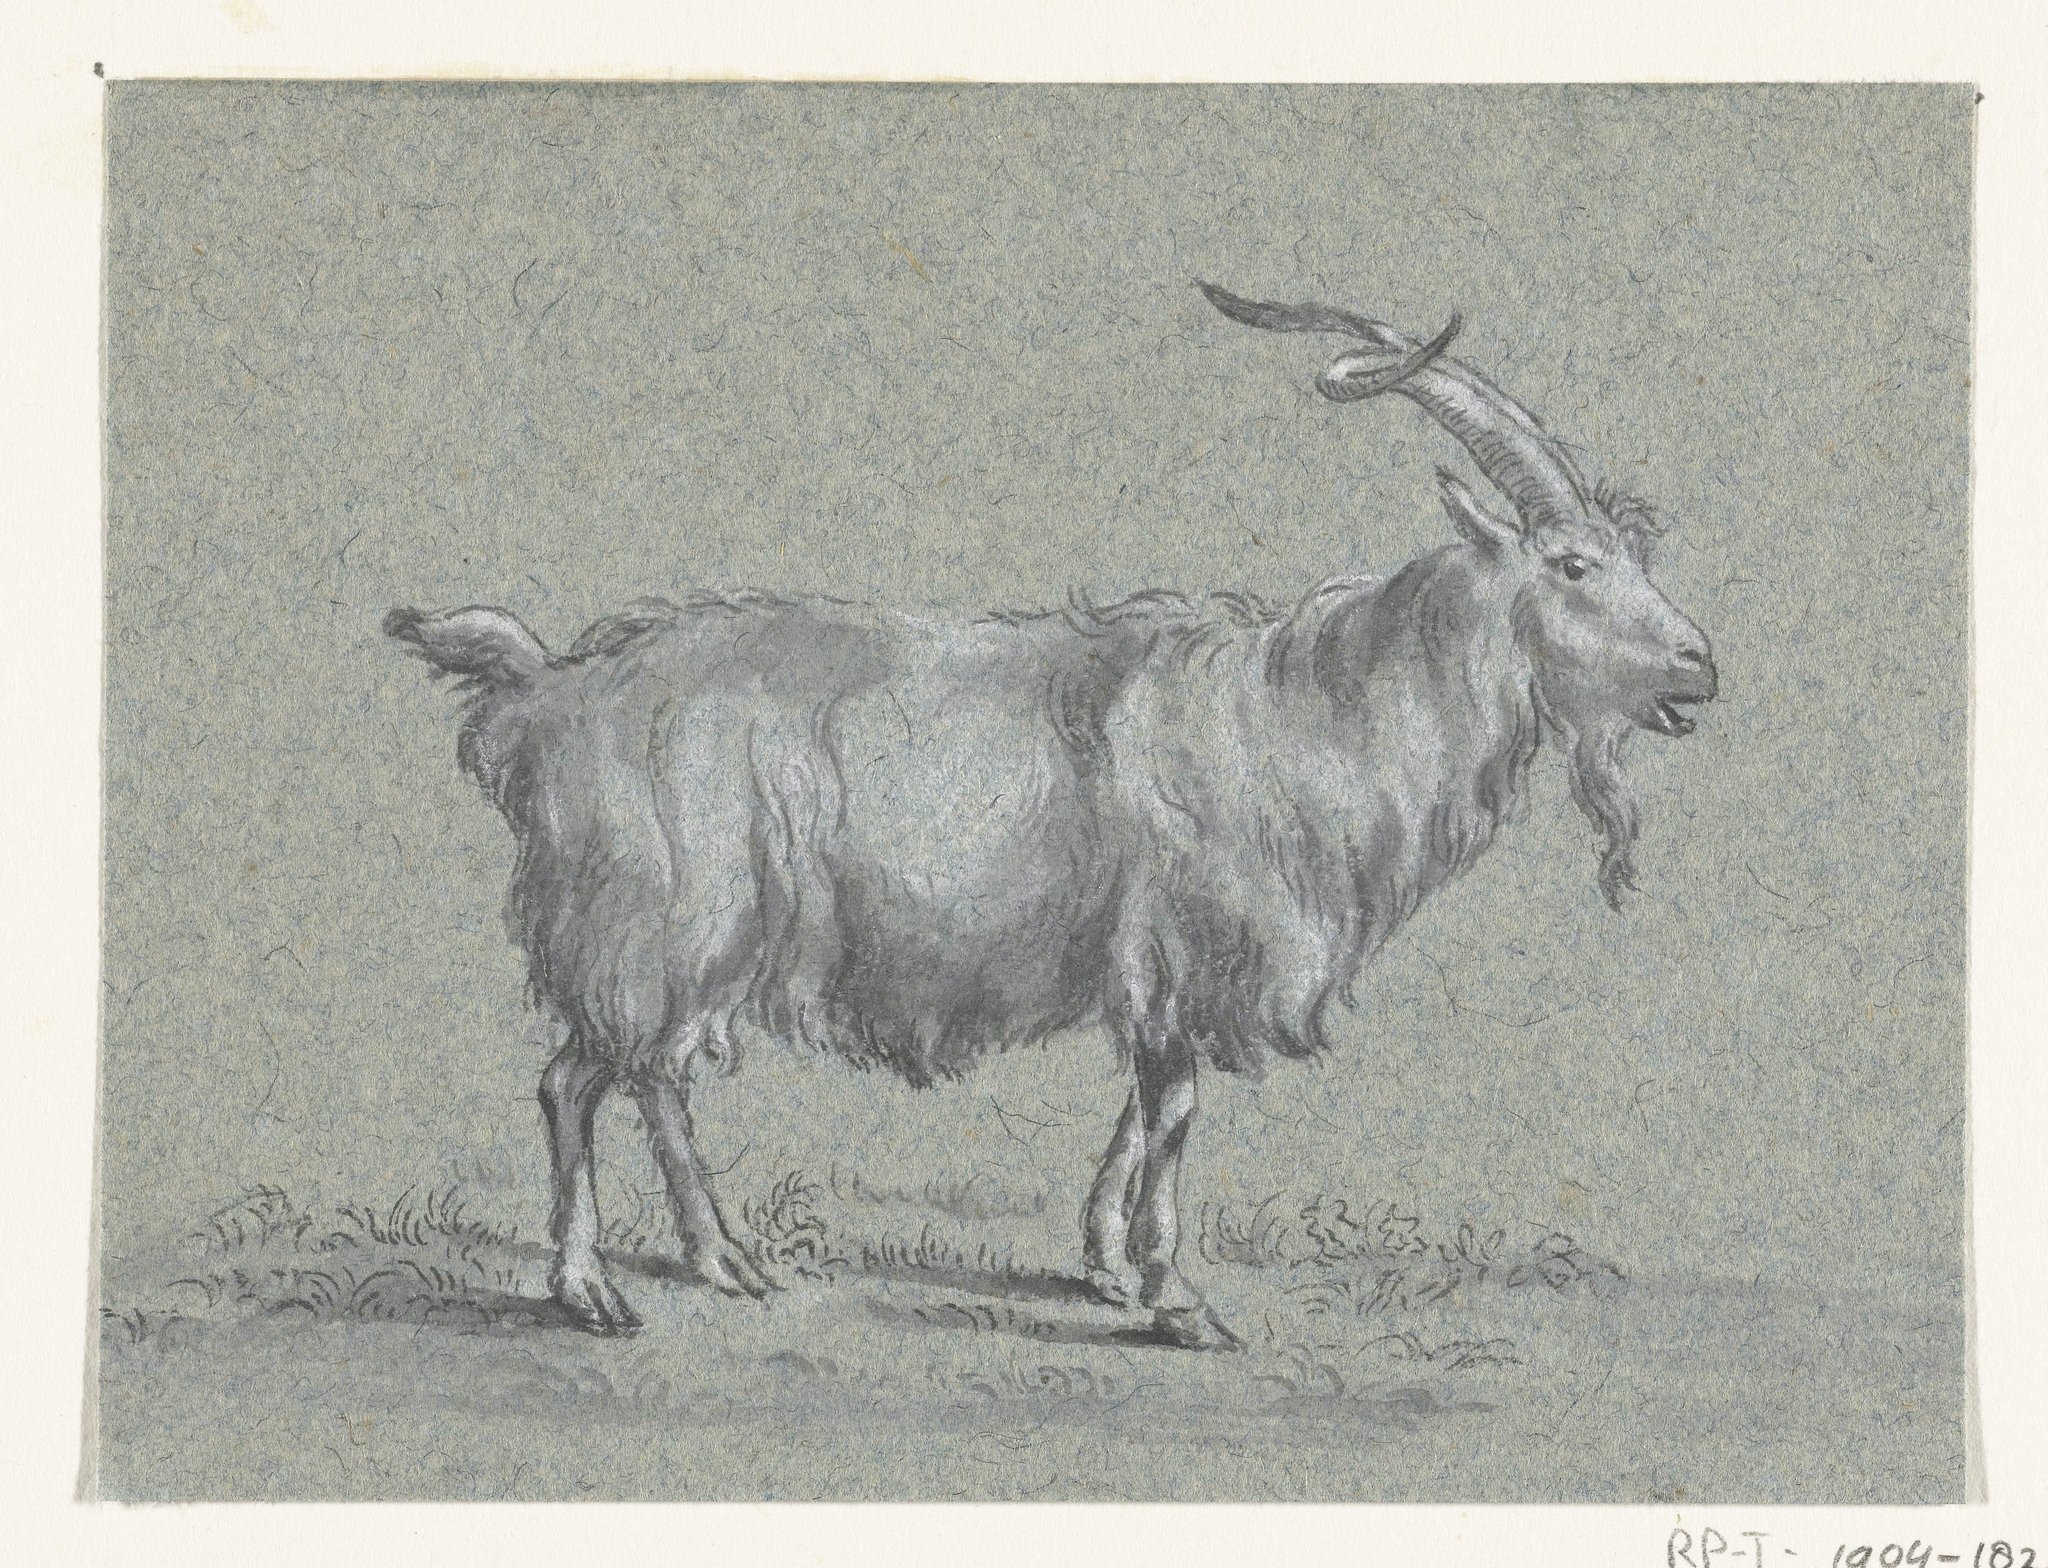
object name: drawing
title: Staande geit, naar rechts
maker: jean bernard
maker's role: draughtsman, print maker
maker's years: 1765-1833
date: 1775-1833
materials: chalk, ink, paper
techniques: brush, pen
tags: goat